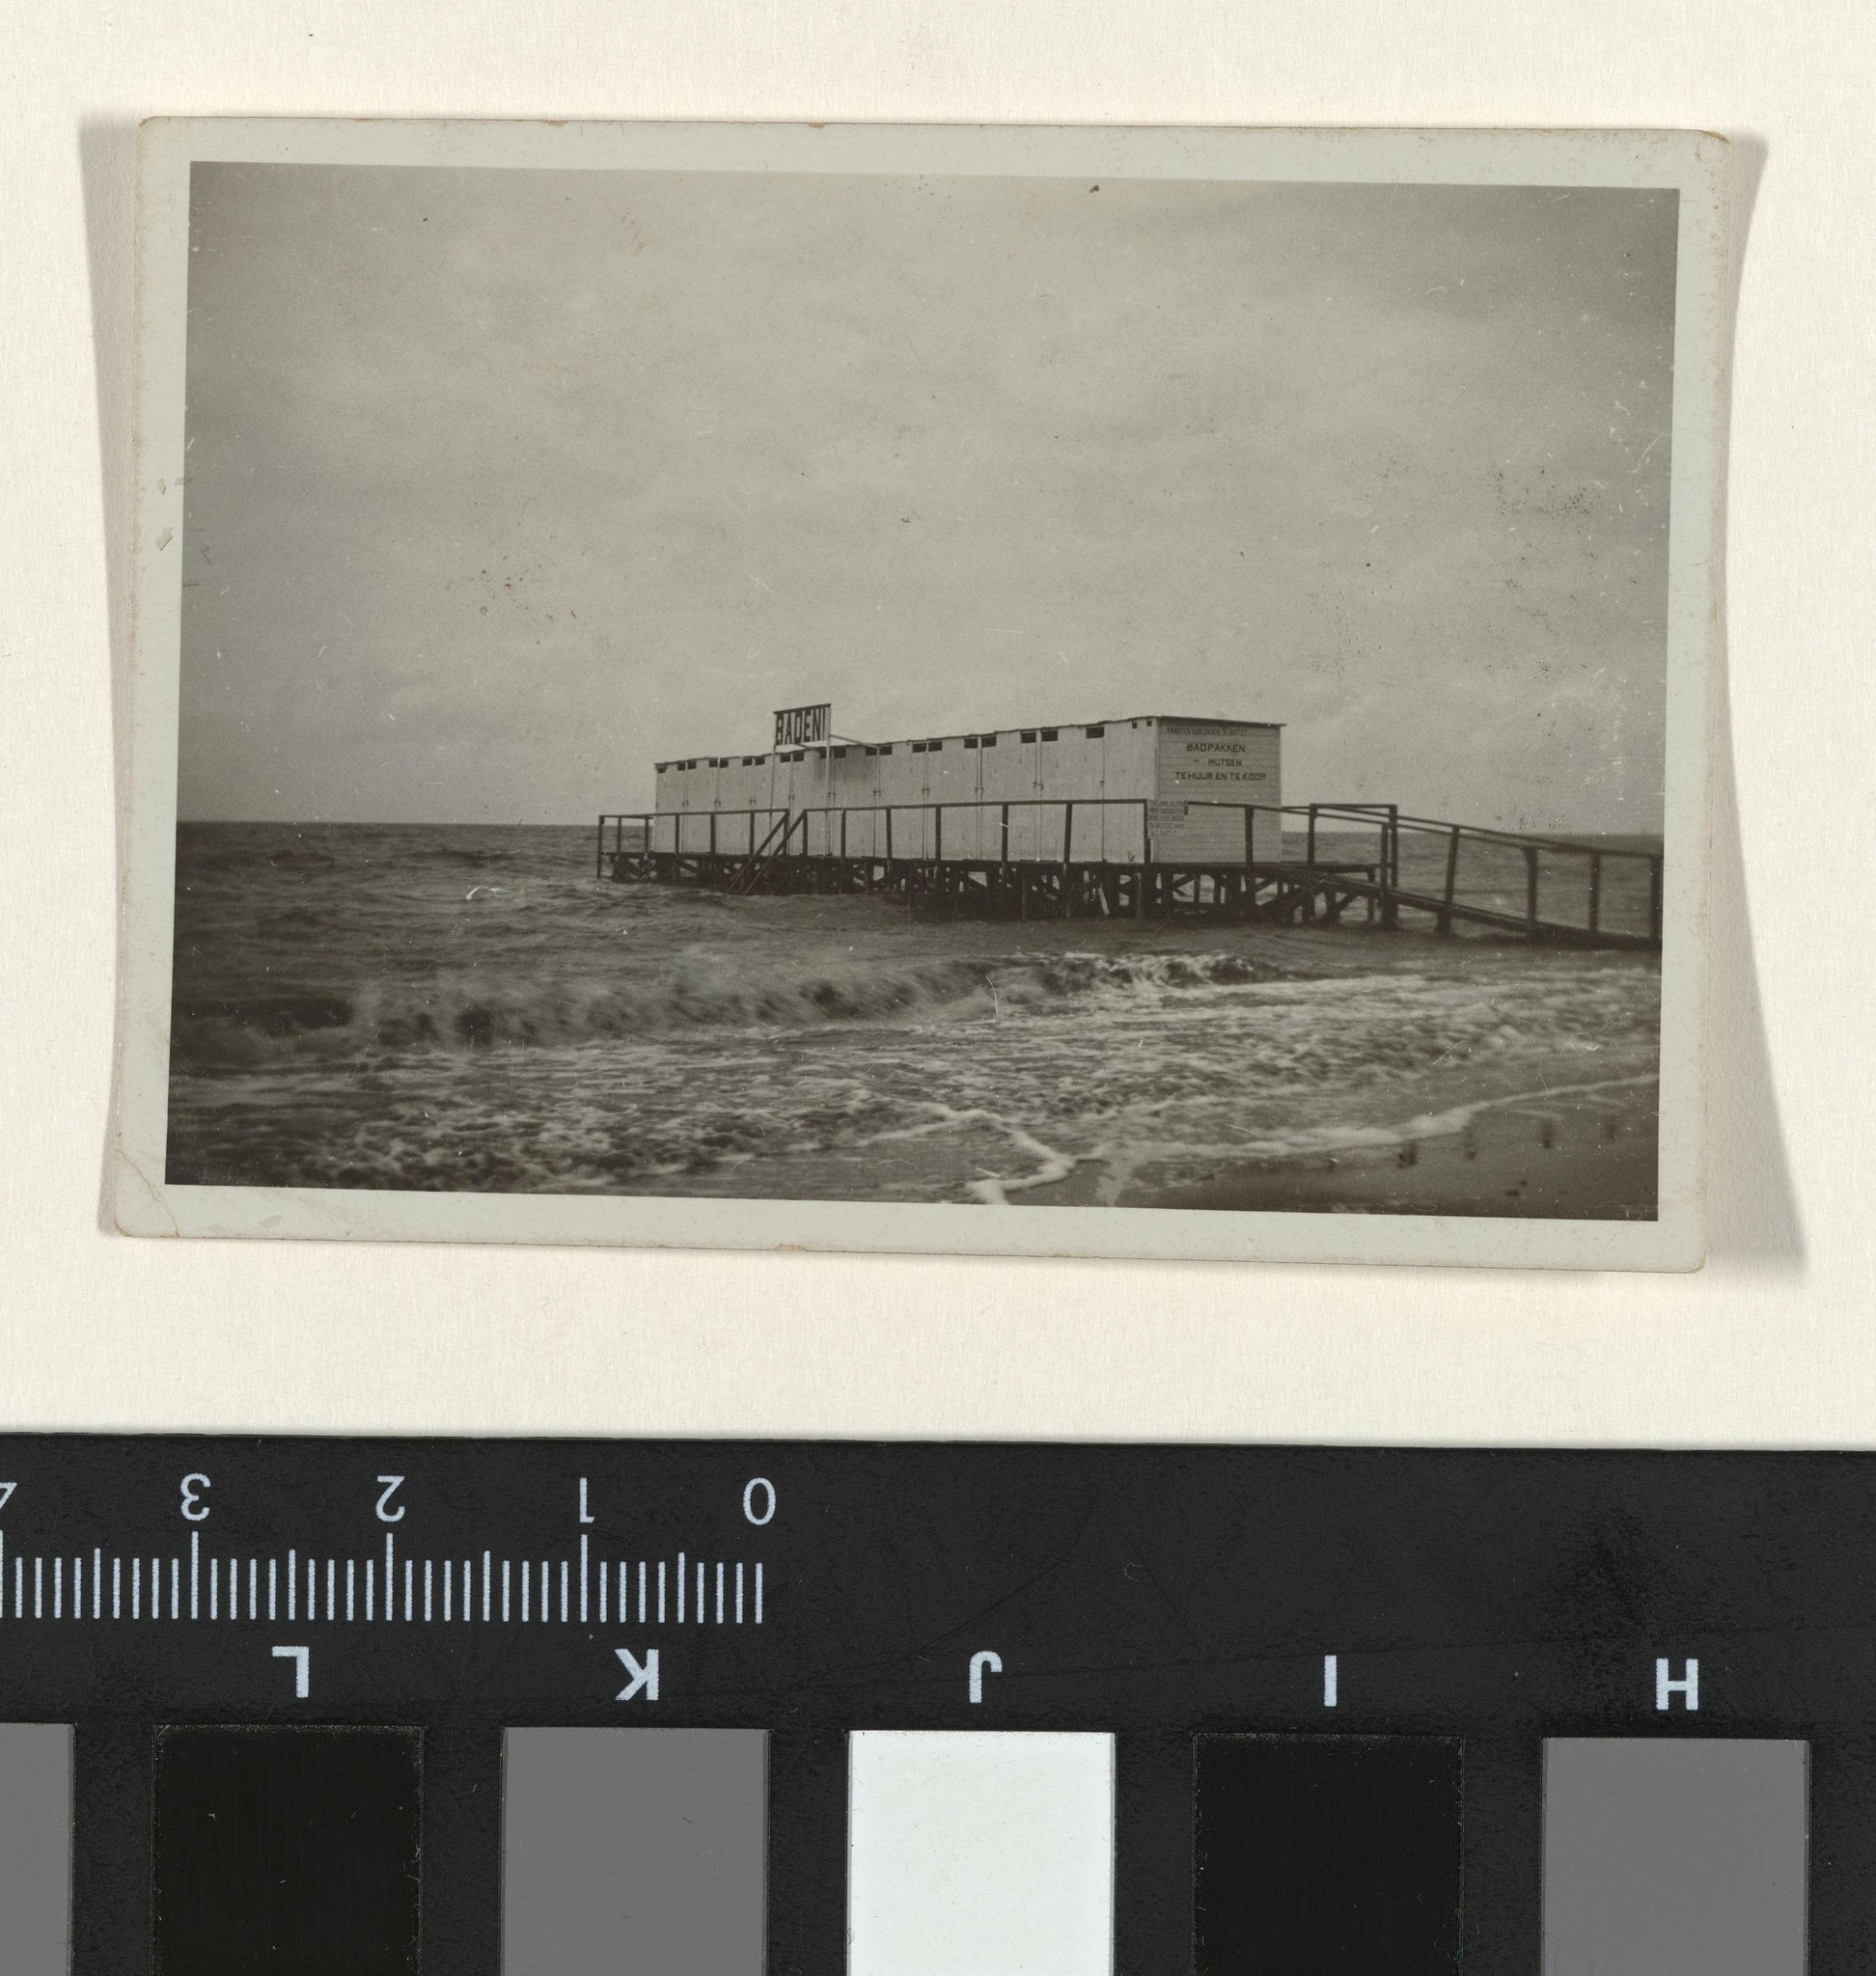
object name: photograph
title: Pier met kleedkamers in de Zuiderzee bij het strand van Valkeveen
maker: Anonymous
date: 1925-1950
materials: paper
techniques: gelatin silver print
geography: valkeveen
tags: pier, quay, wharf, zuiderzee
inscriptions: inscription: ‘AI’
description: Pier met badhokjes bij het strand van Vinkeveen.